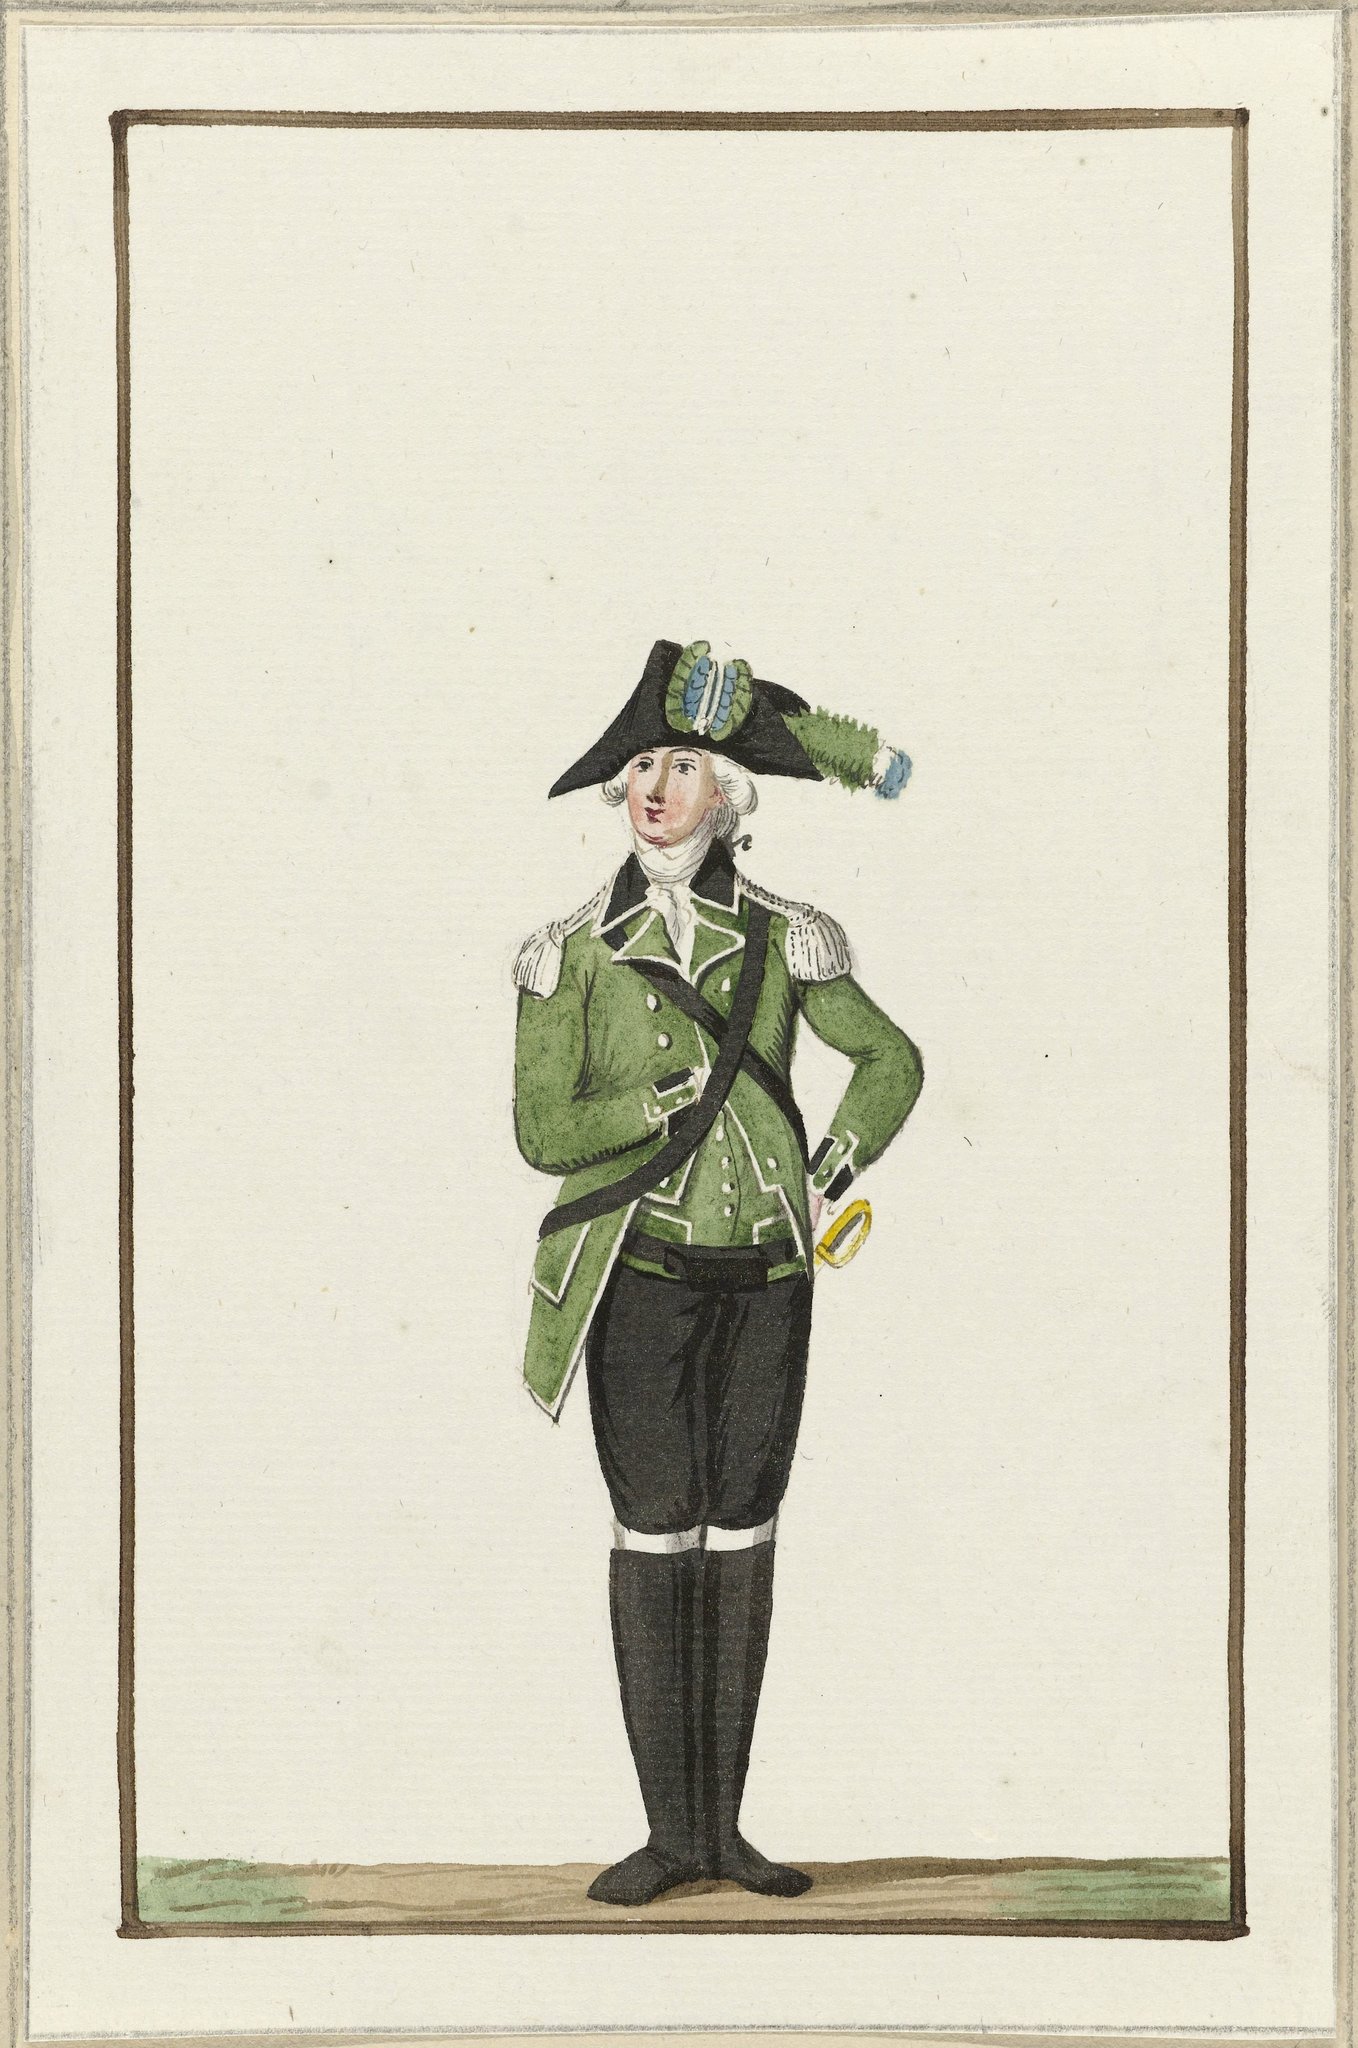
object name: drawing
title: Montering van de jagers van Kampen, ca. 1787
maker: Anonymous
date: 1787-1790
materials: paper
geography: northern netherlands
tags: (military) uniforms (+ citizen soldiery, civil guard, citizen militia), patriots (1780-1795)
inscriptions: collector's mark: Lugt 2228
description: Uniform van de jagers van Kampen. Onderdeel van een serie van 32 tekeningen van de verschillende monteringen (uniformen) van patriotse schutterijen en burgerkorpsen in Nederland in 1787.